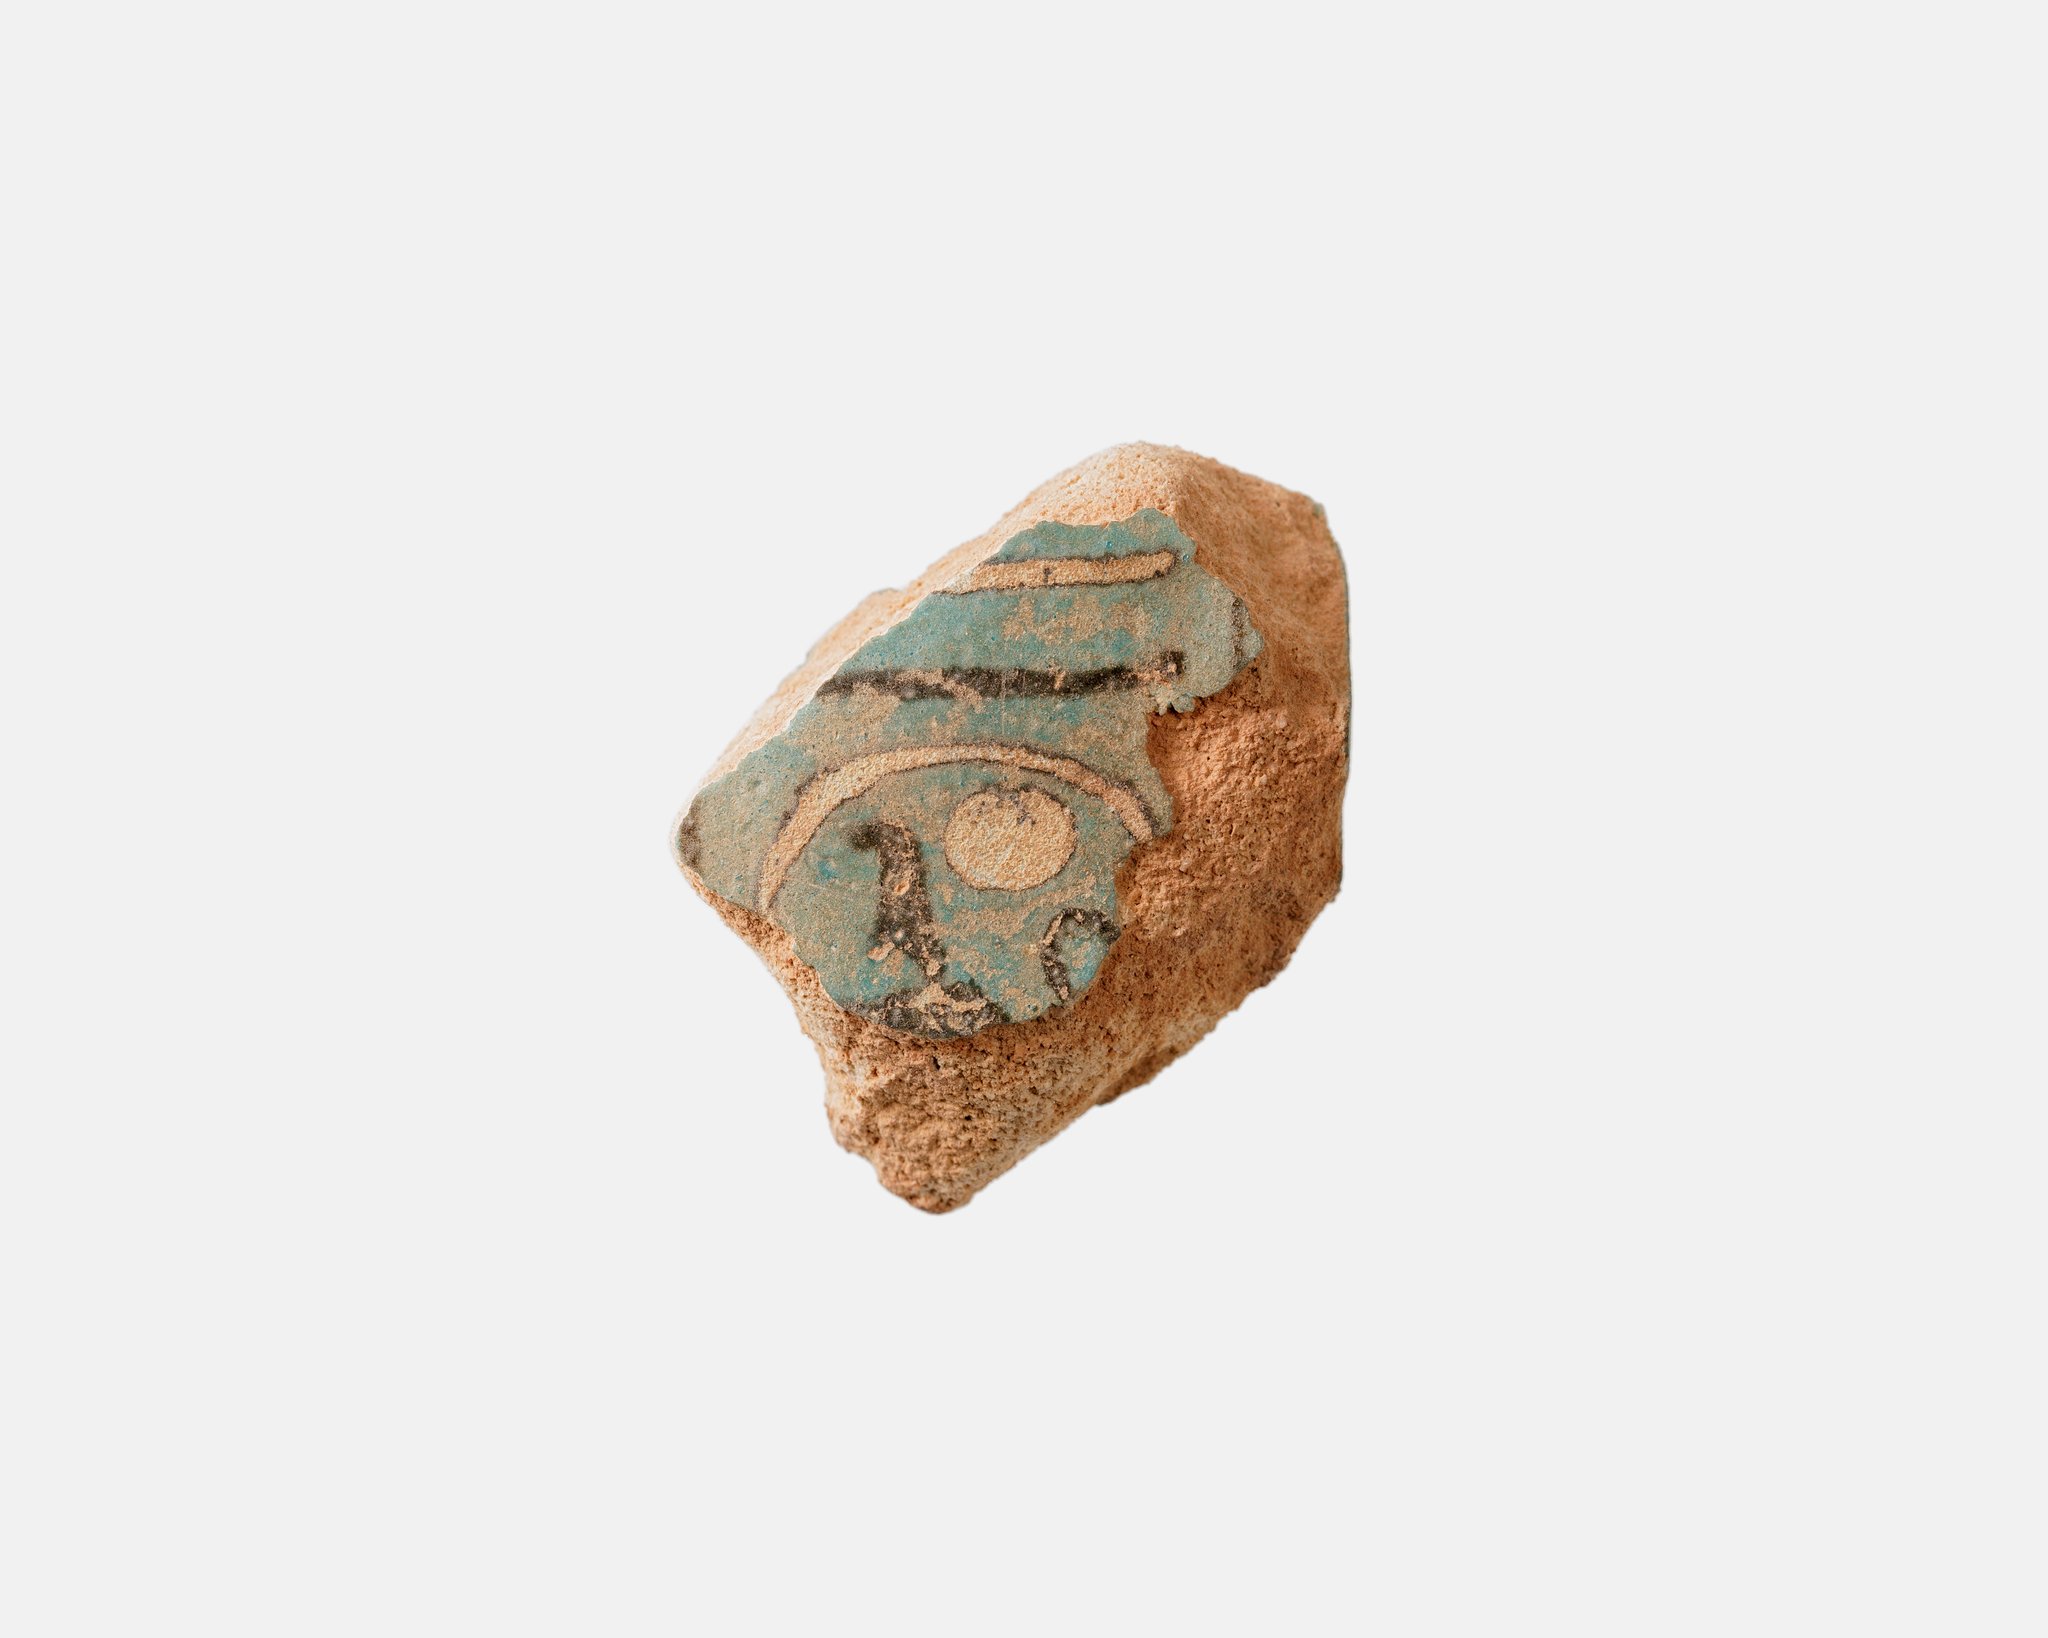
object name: votive tile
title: Fragment of a votive tile with cartouche of Ramesses IV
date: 1153-1147 BCE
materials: faience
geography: egypt